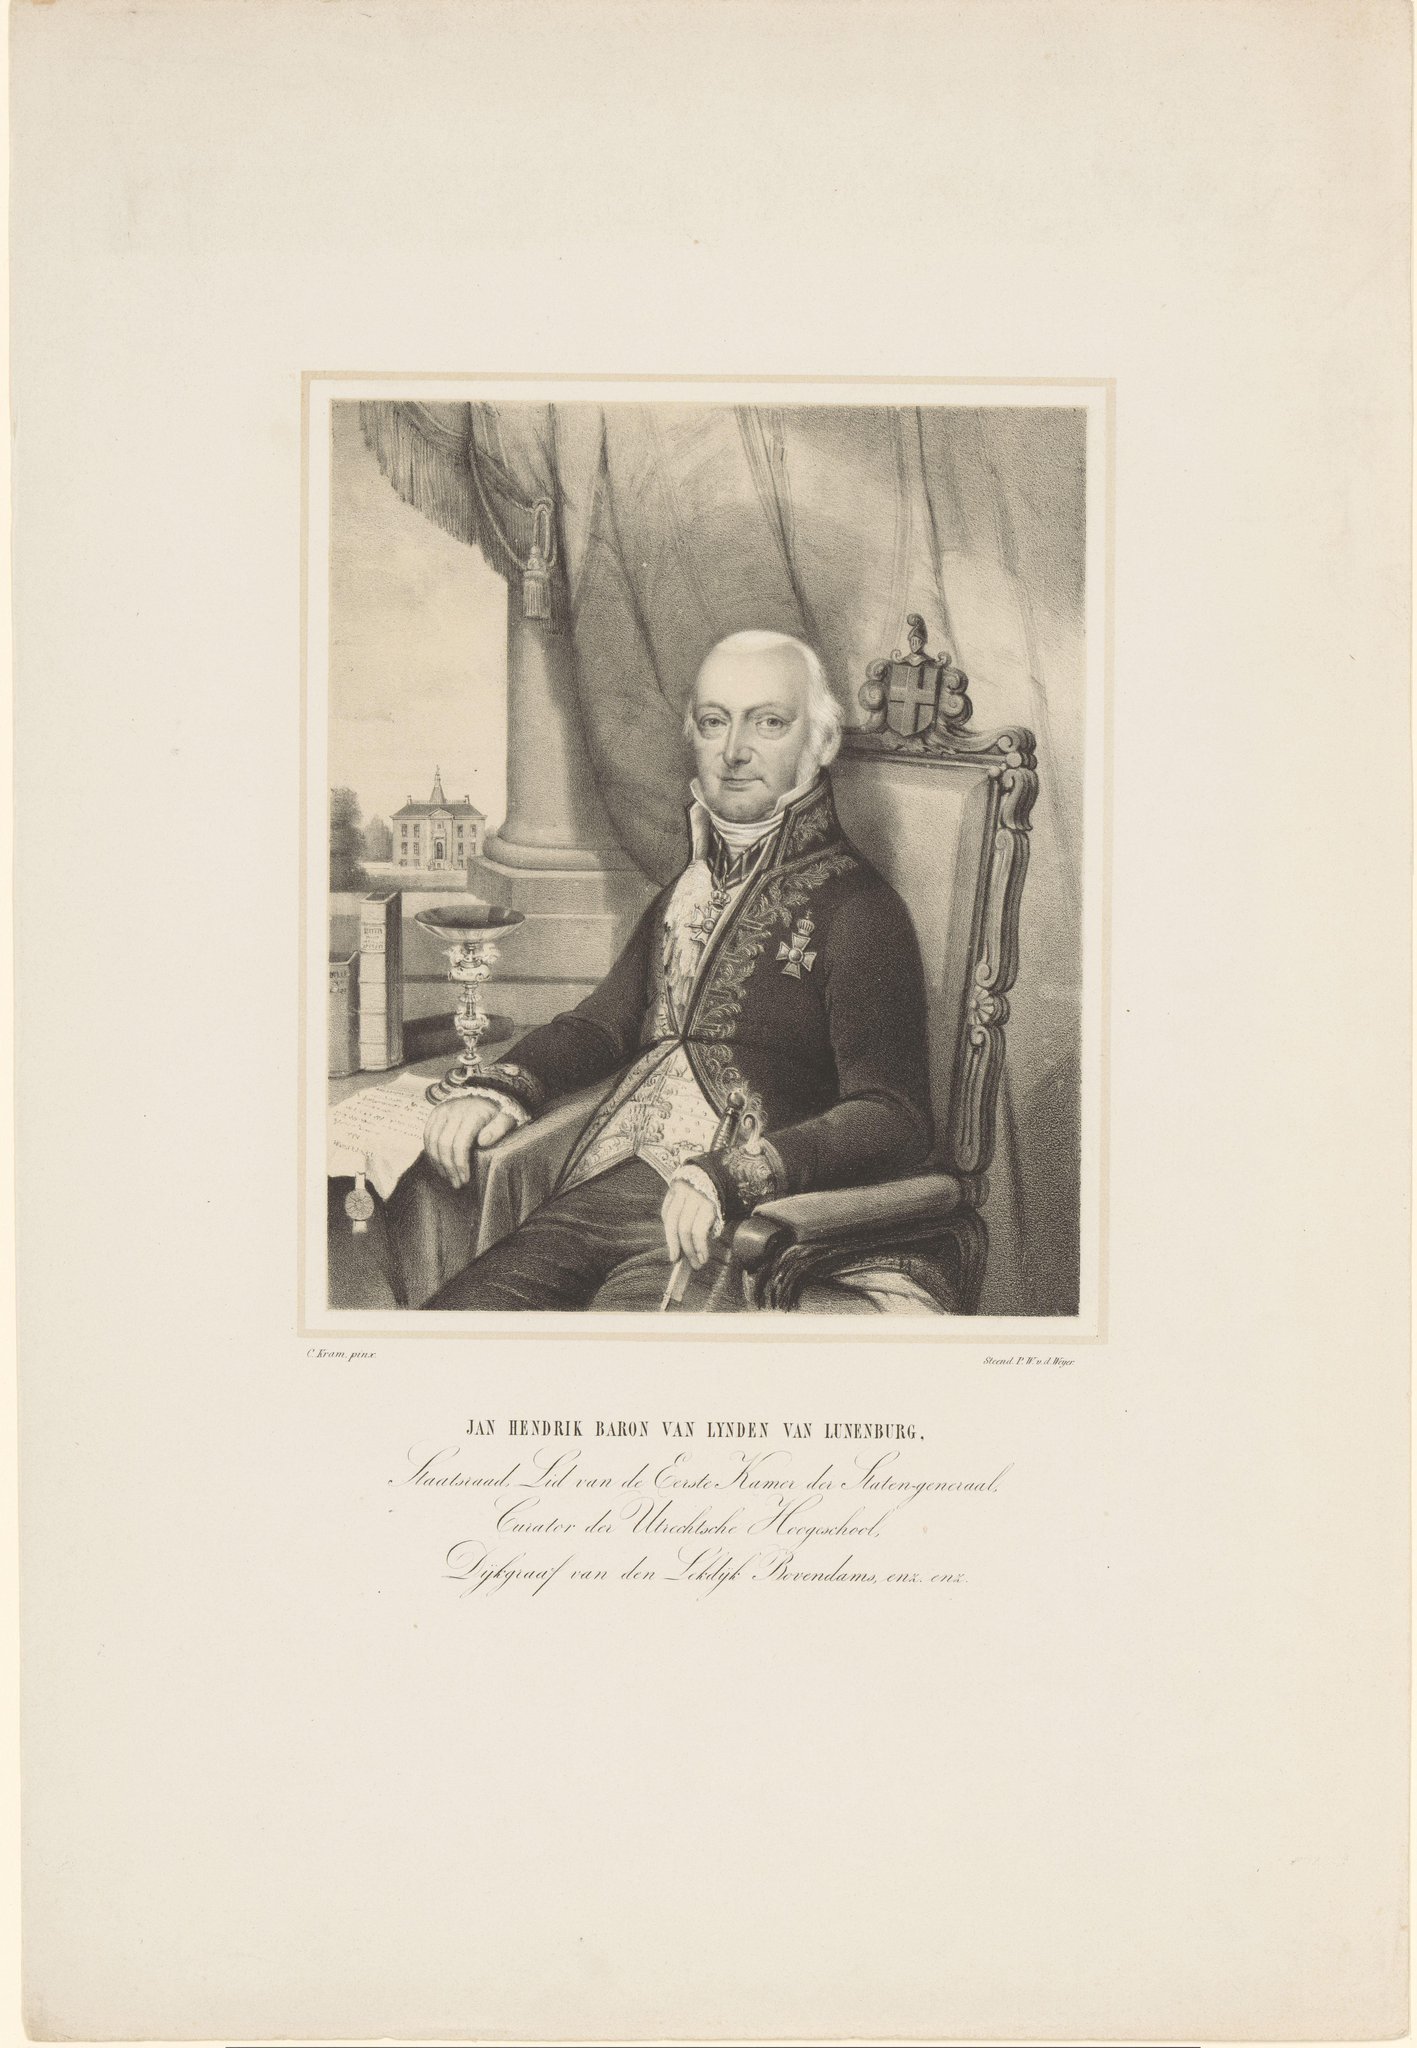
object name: print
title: Portret van Jan Hendrik Lynden van Lunenburg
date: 1843-1880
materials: paper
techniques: tone lithography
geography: utrecht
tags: politician, castle, cup, historical persons (+ three-quarter length portrait)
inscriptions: collector's mark: Lugt 2228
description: De geportretteerde zit in een stoel naast een tafel met daarop een tazza, een brief of akte met zegel en twee boeken. Achter hem een opgetrokken gordijn, een zuilen uitzicht op kasteel Lunenburg te Langbroek. Onder het portret een vierregelig onderschrift.